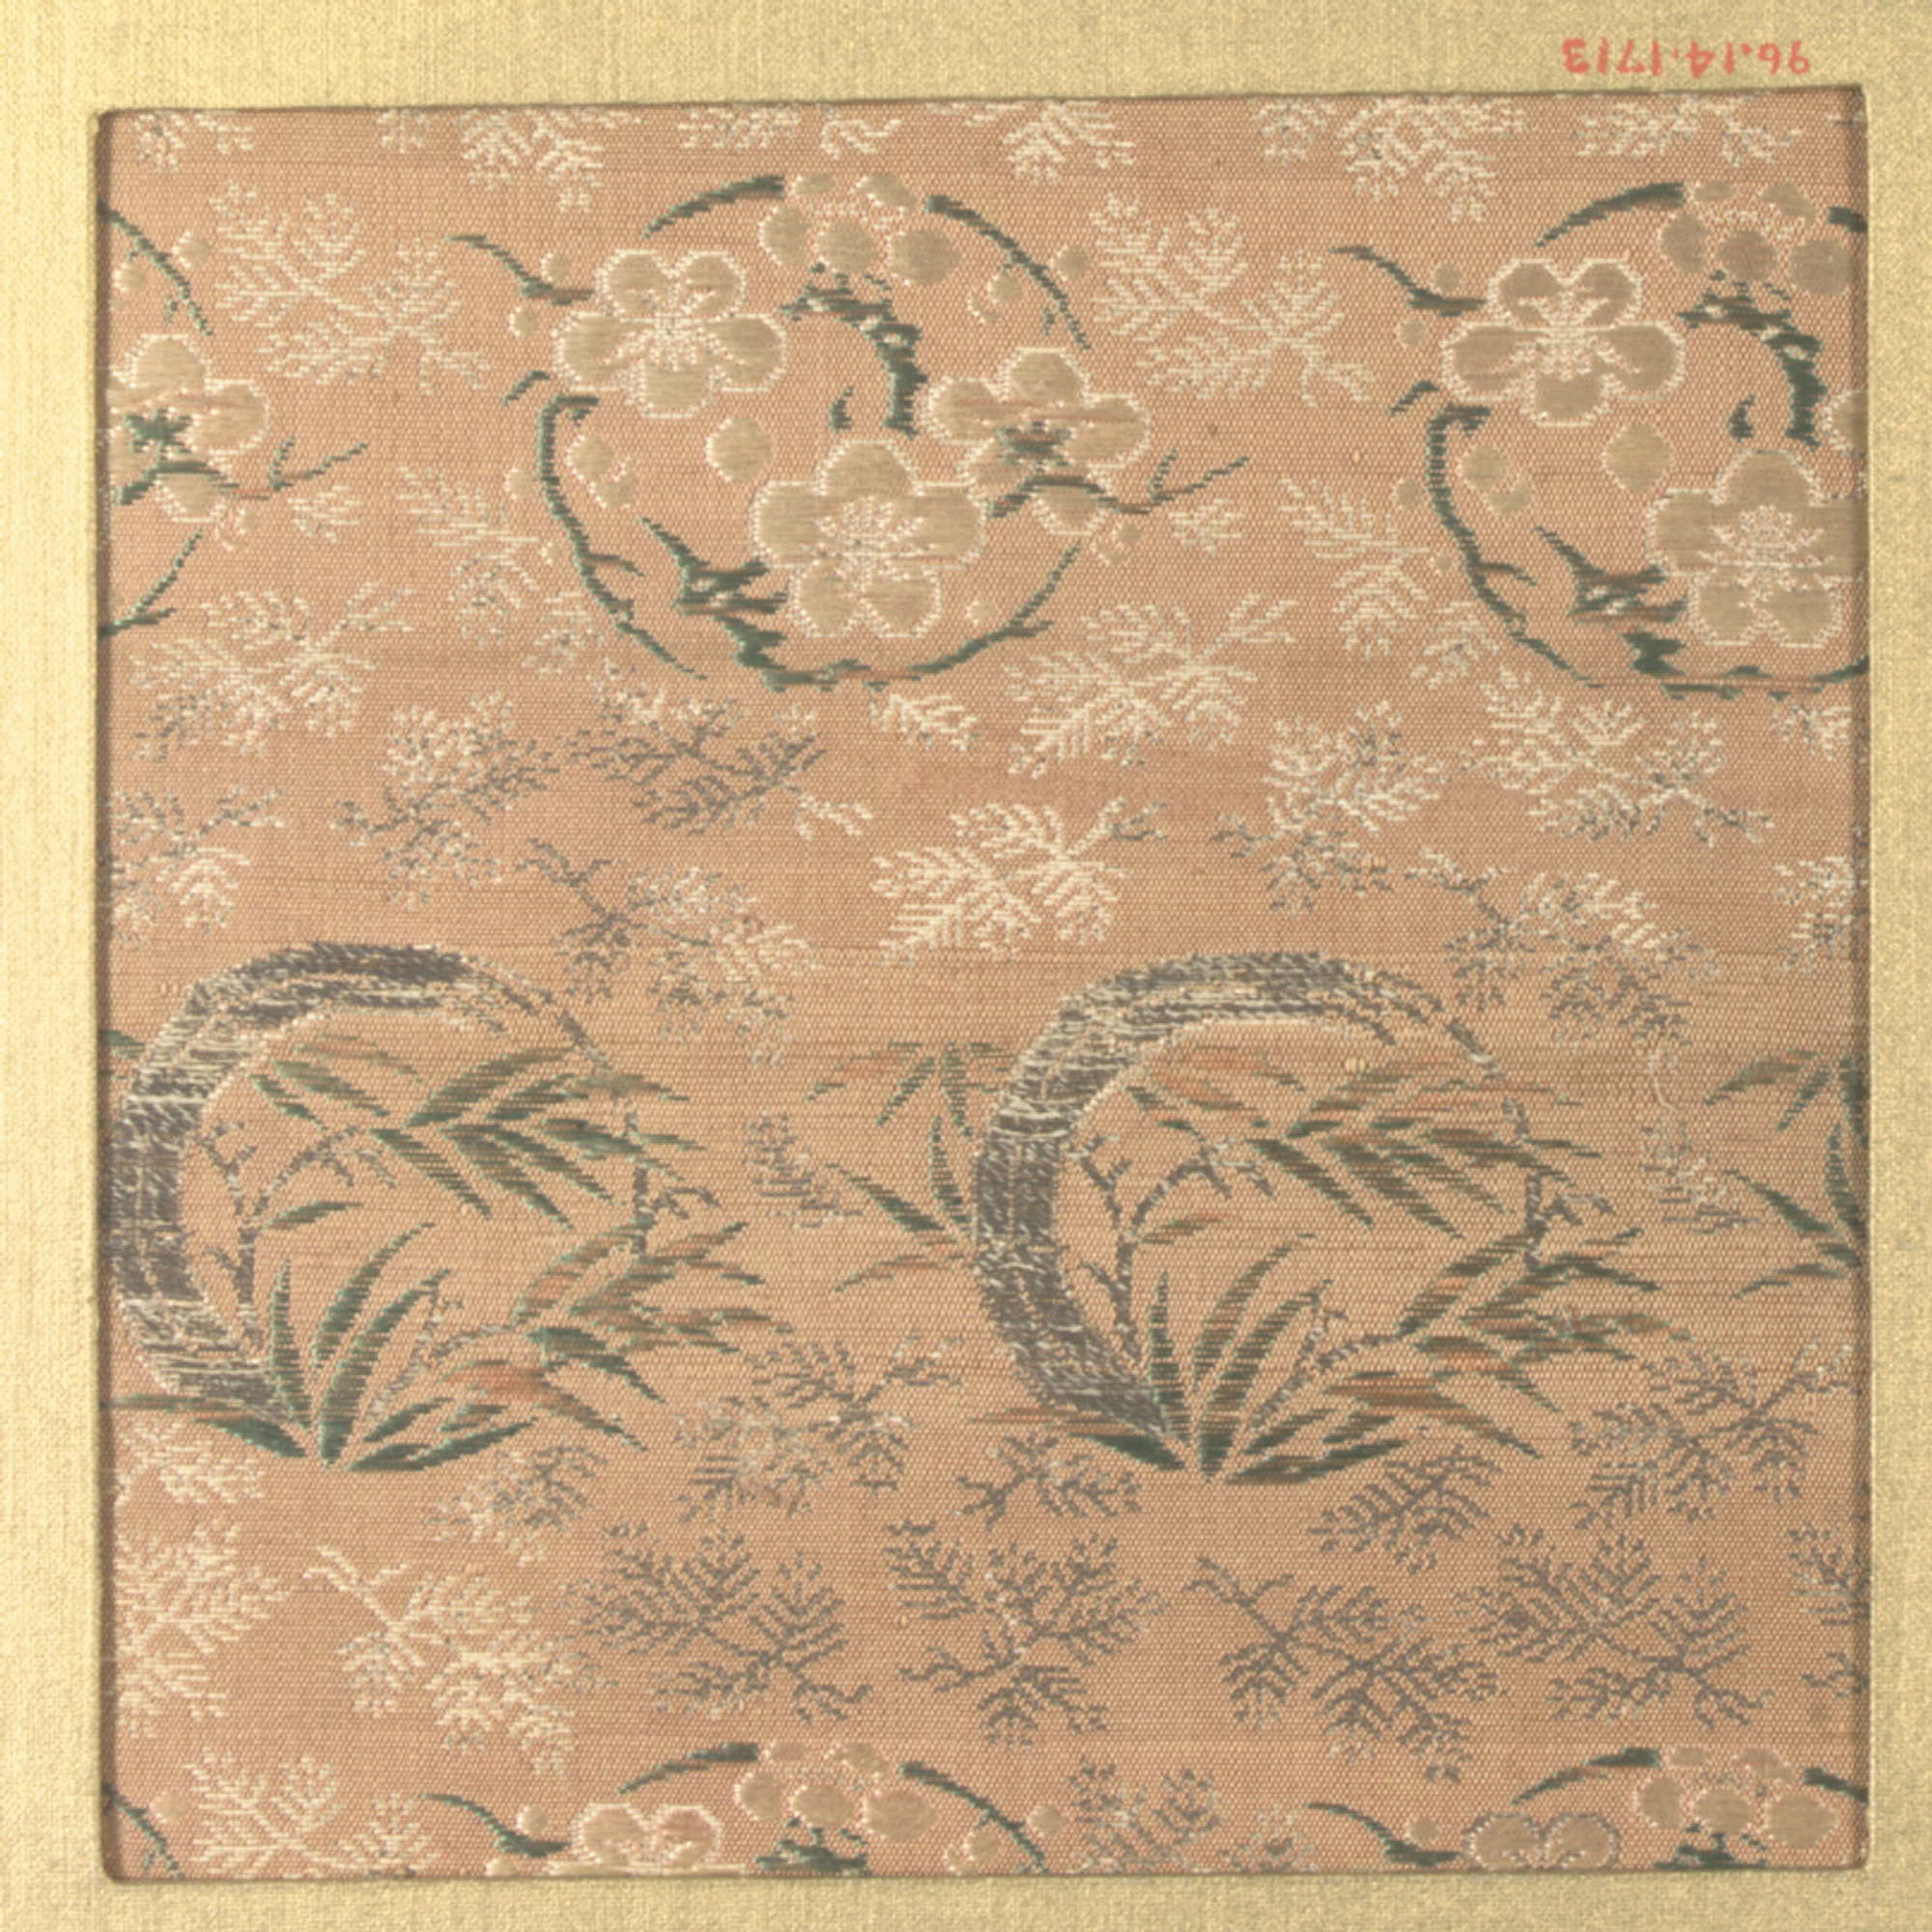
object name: piece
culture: japanese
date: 1701-1900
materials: silk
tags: leaves